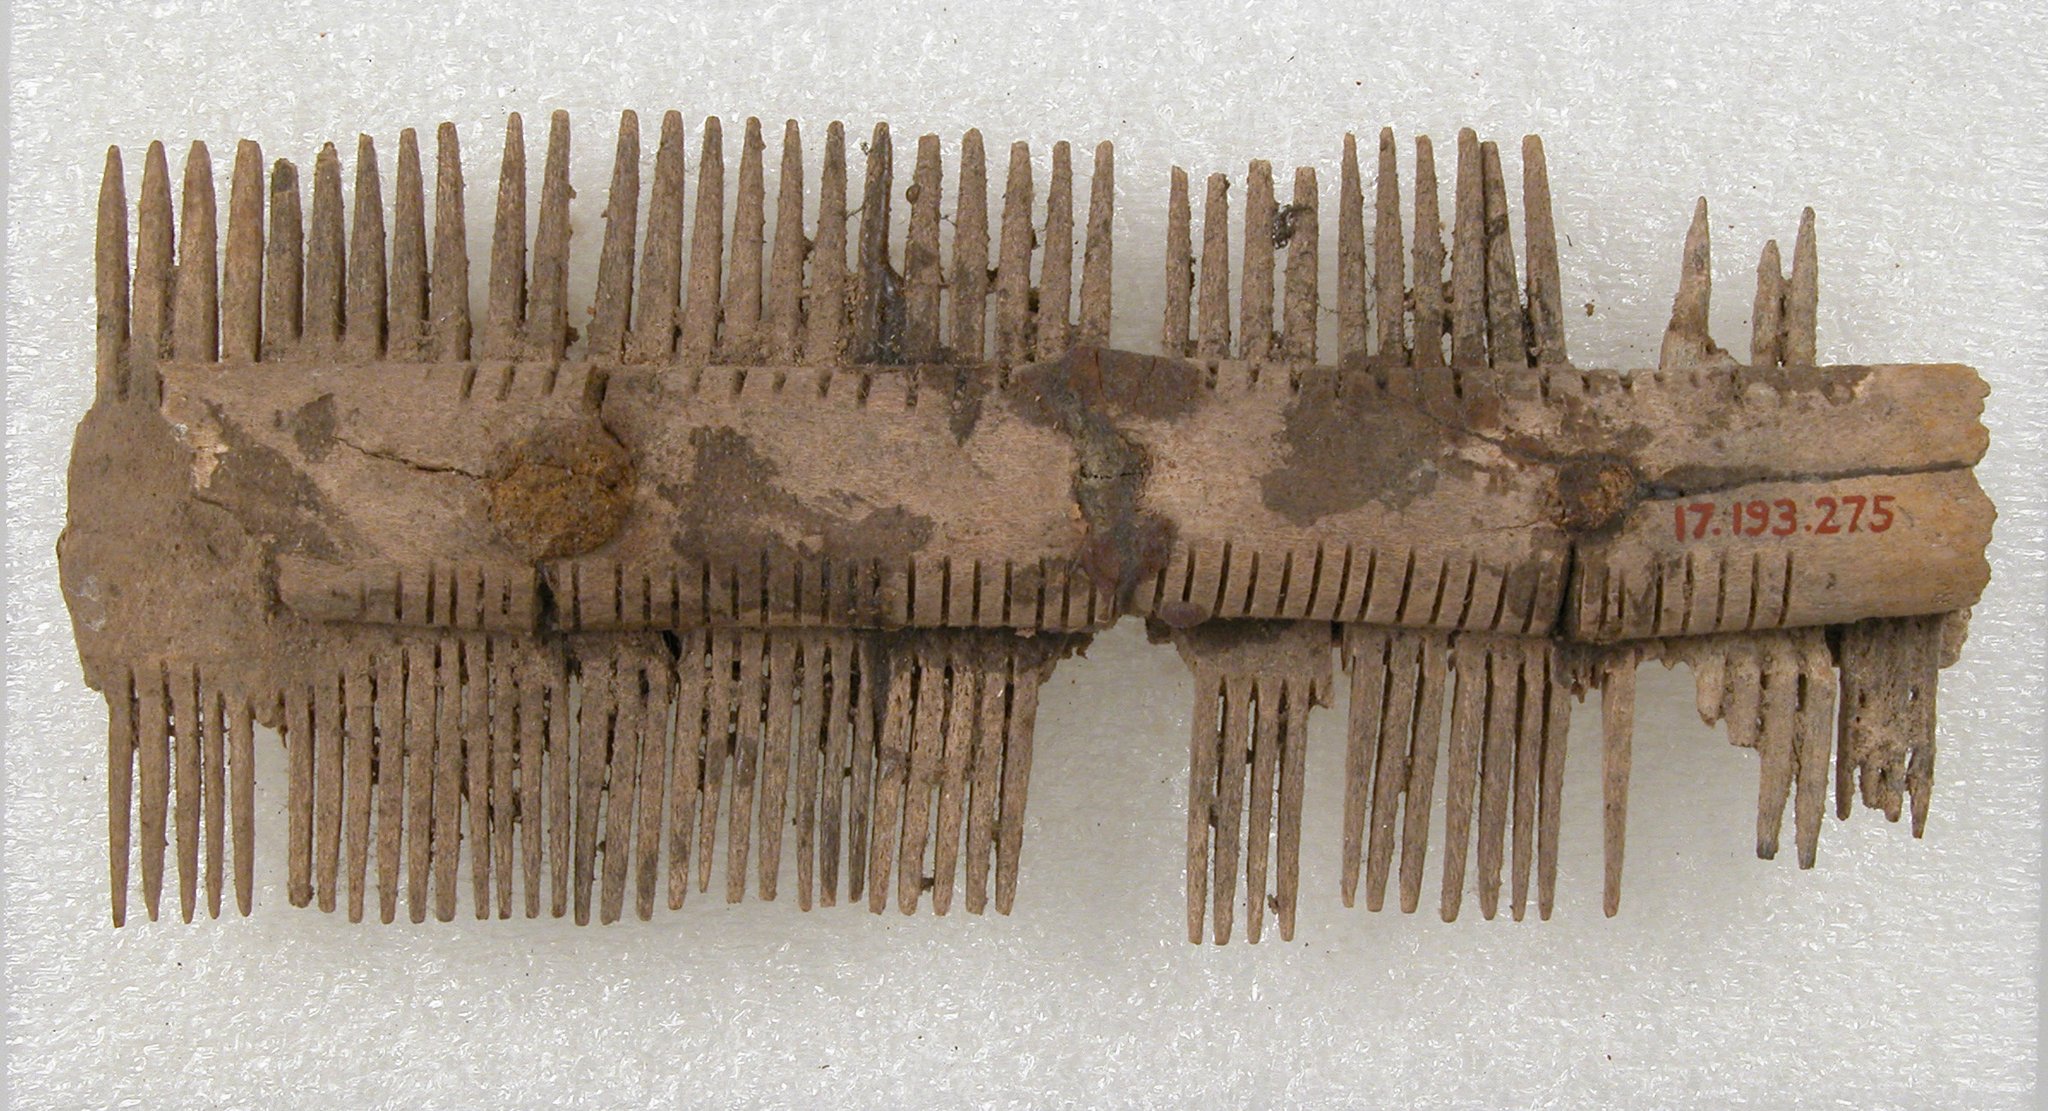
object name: comb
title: Double-Sided Comb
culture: frankish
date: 601-700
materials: bone, iron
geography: germany